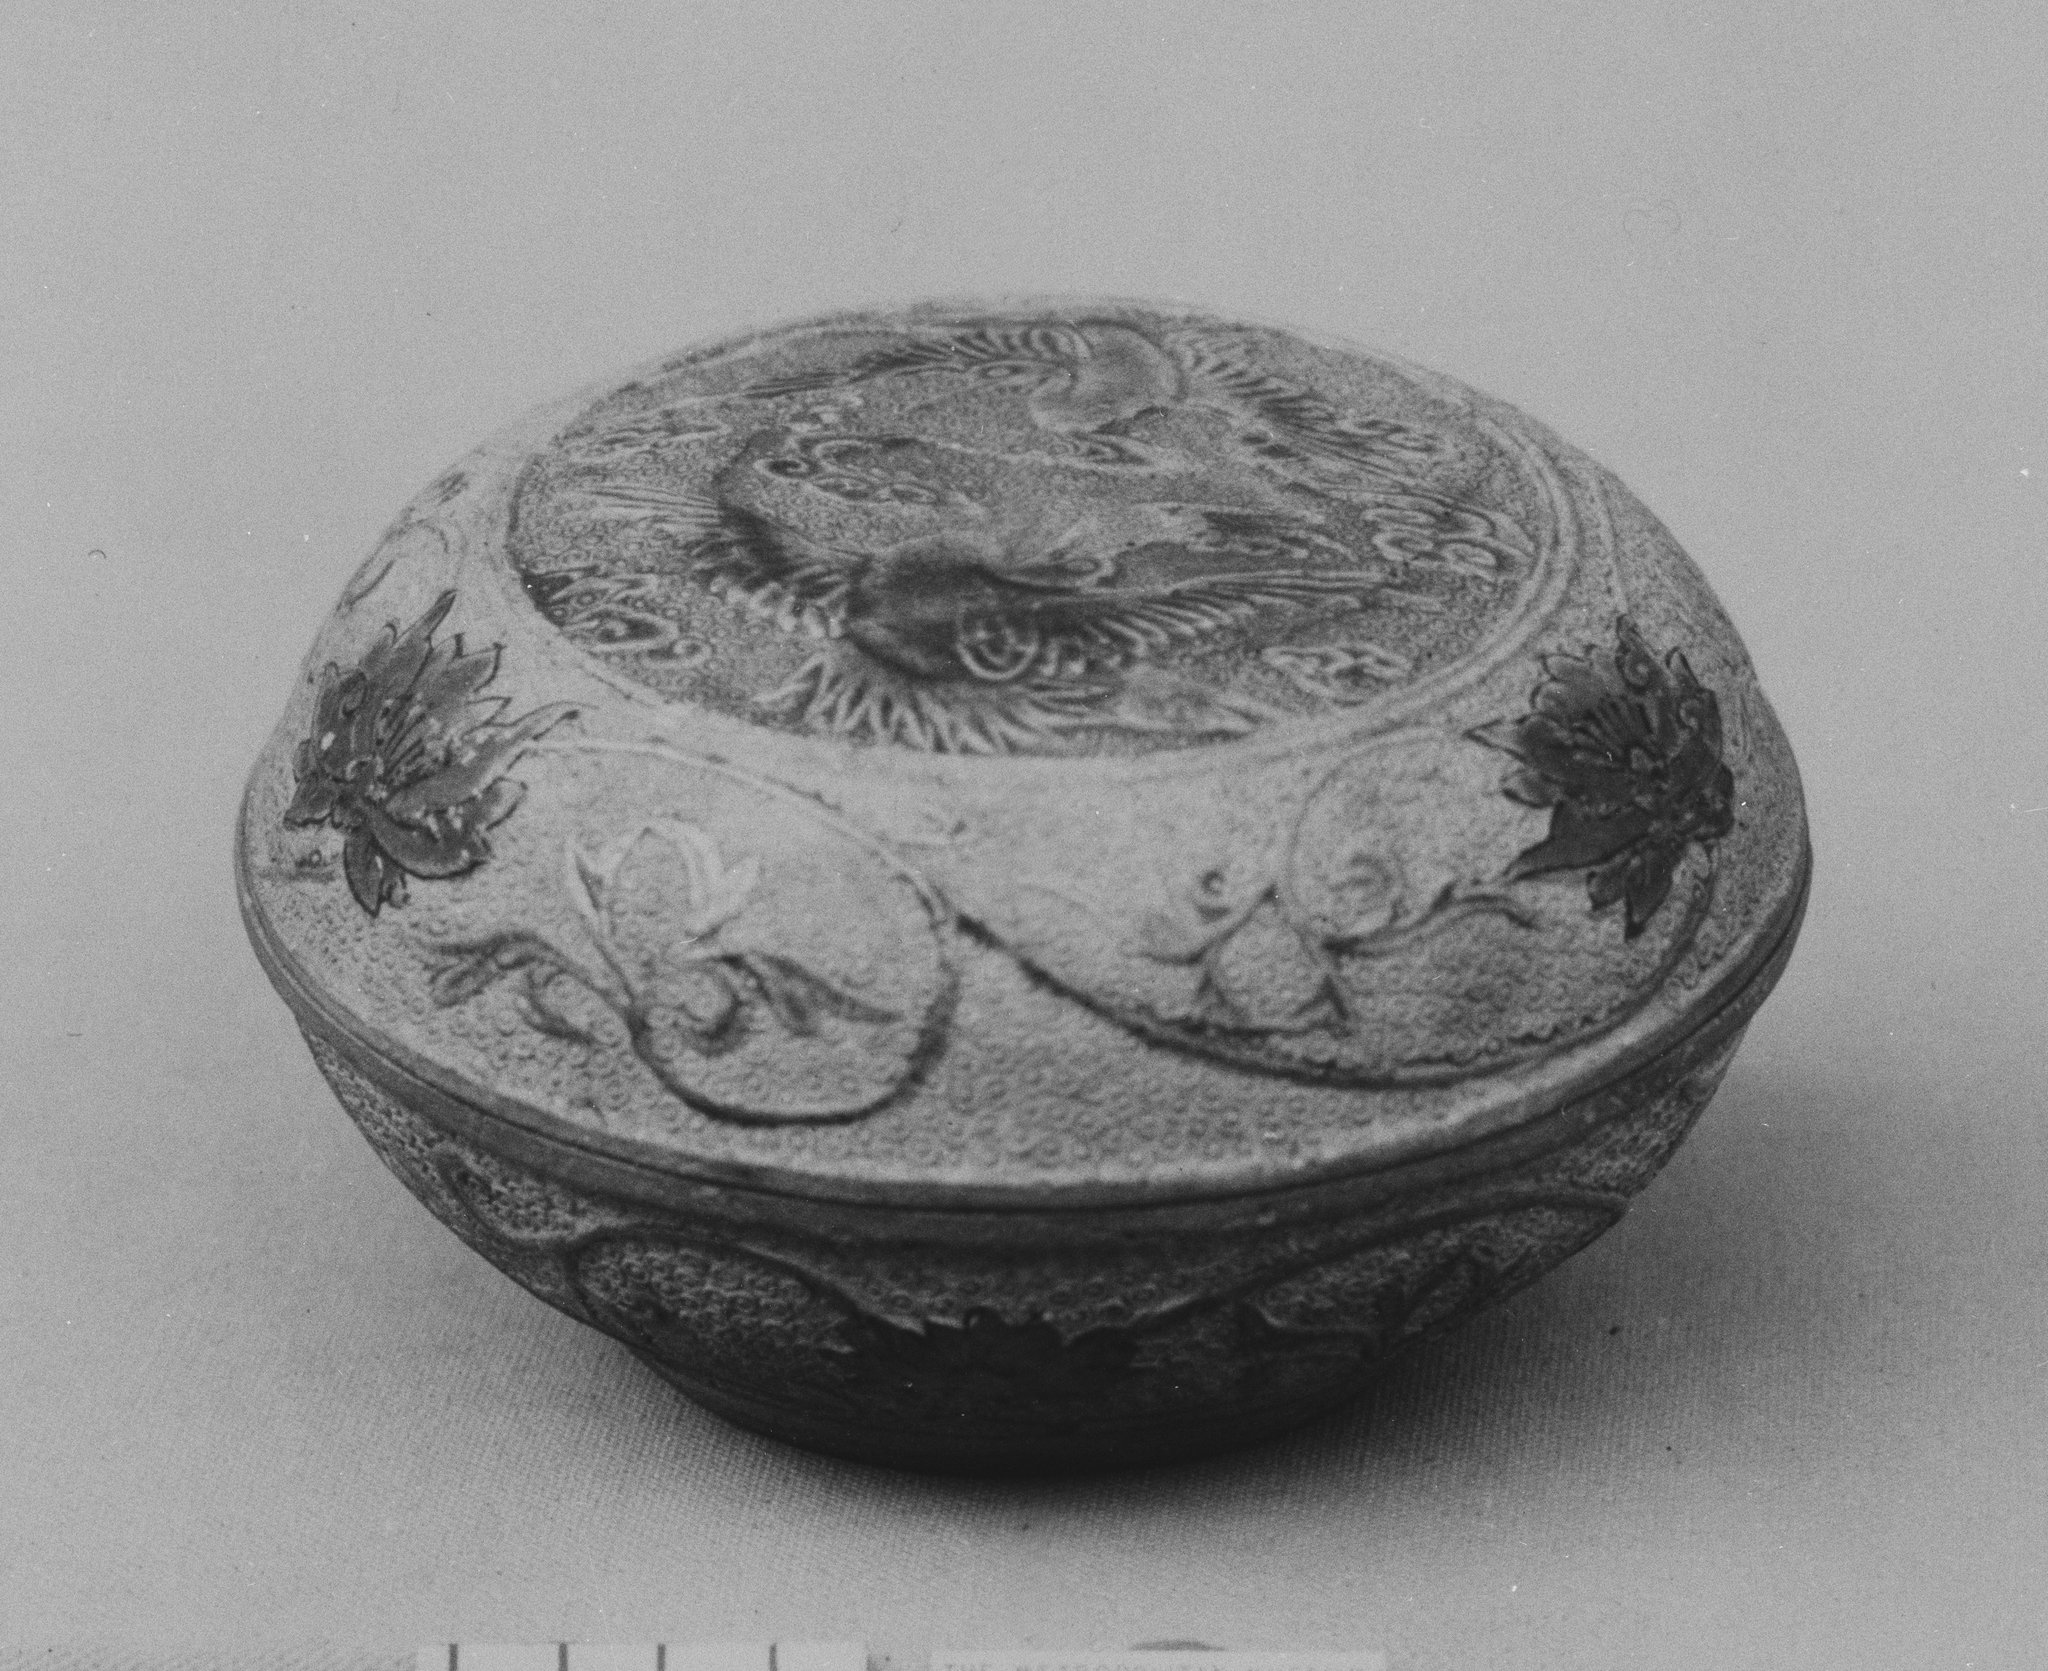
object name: incense box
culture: japanese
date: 1830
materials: enamel, faience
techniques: relief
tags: flowers,leaves